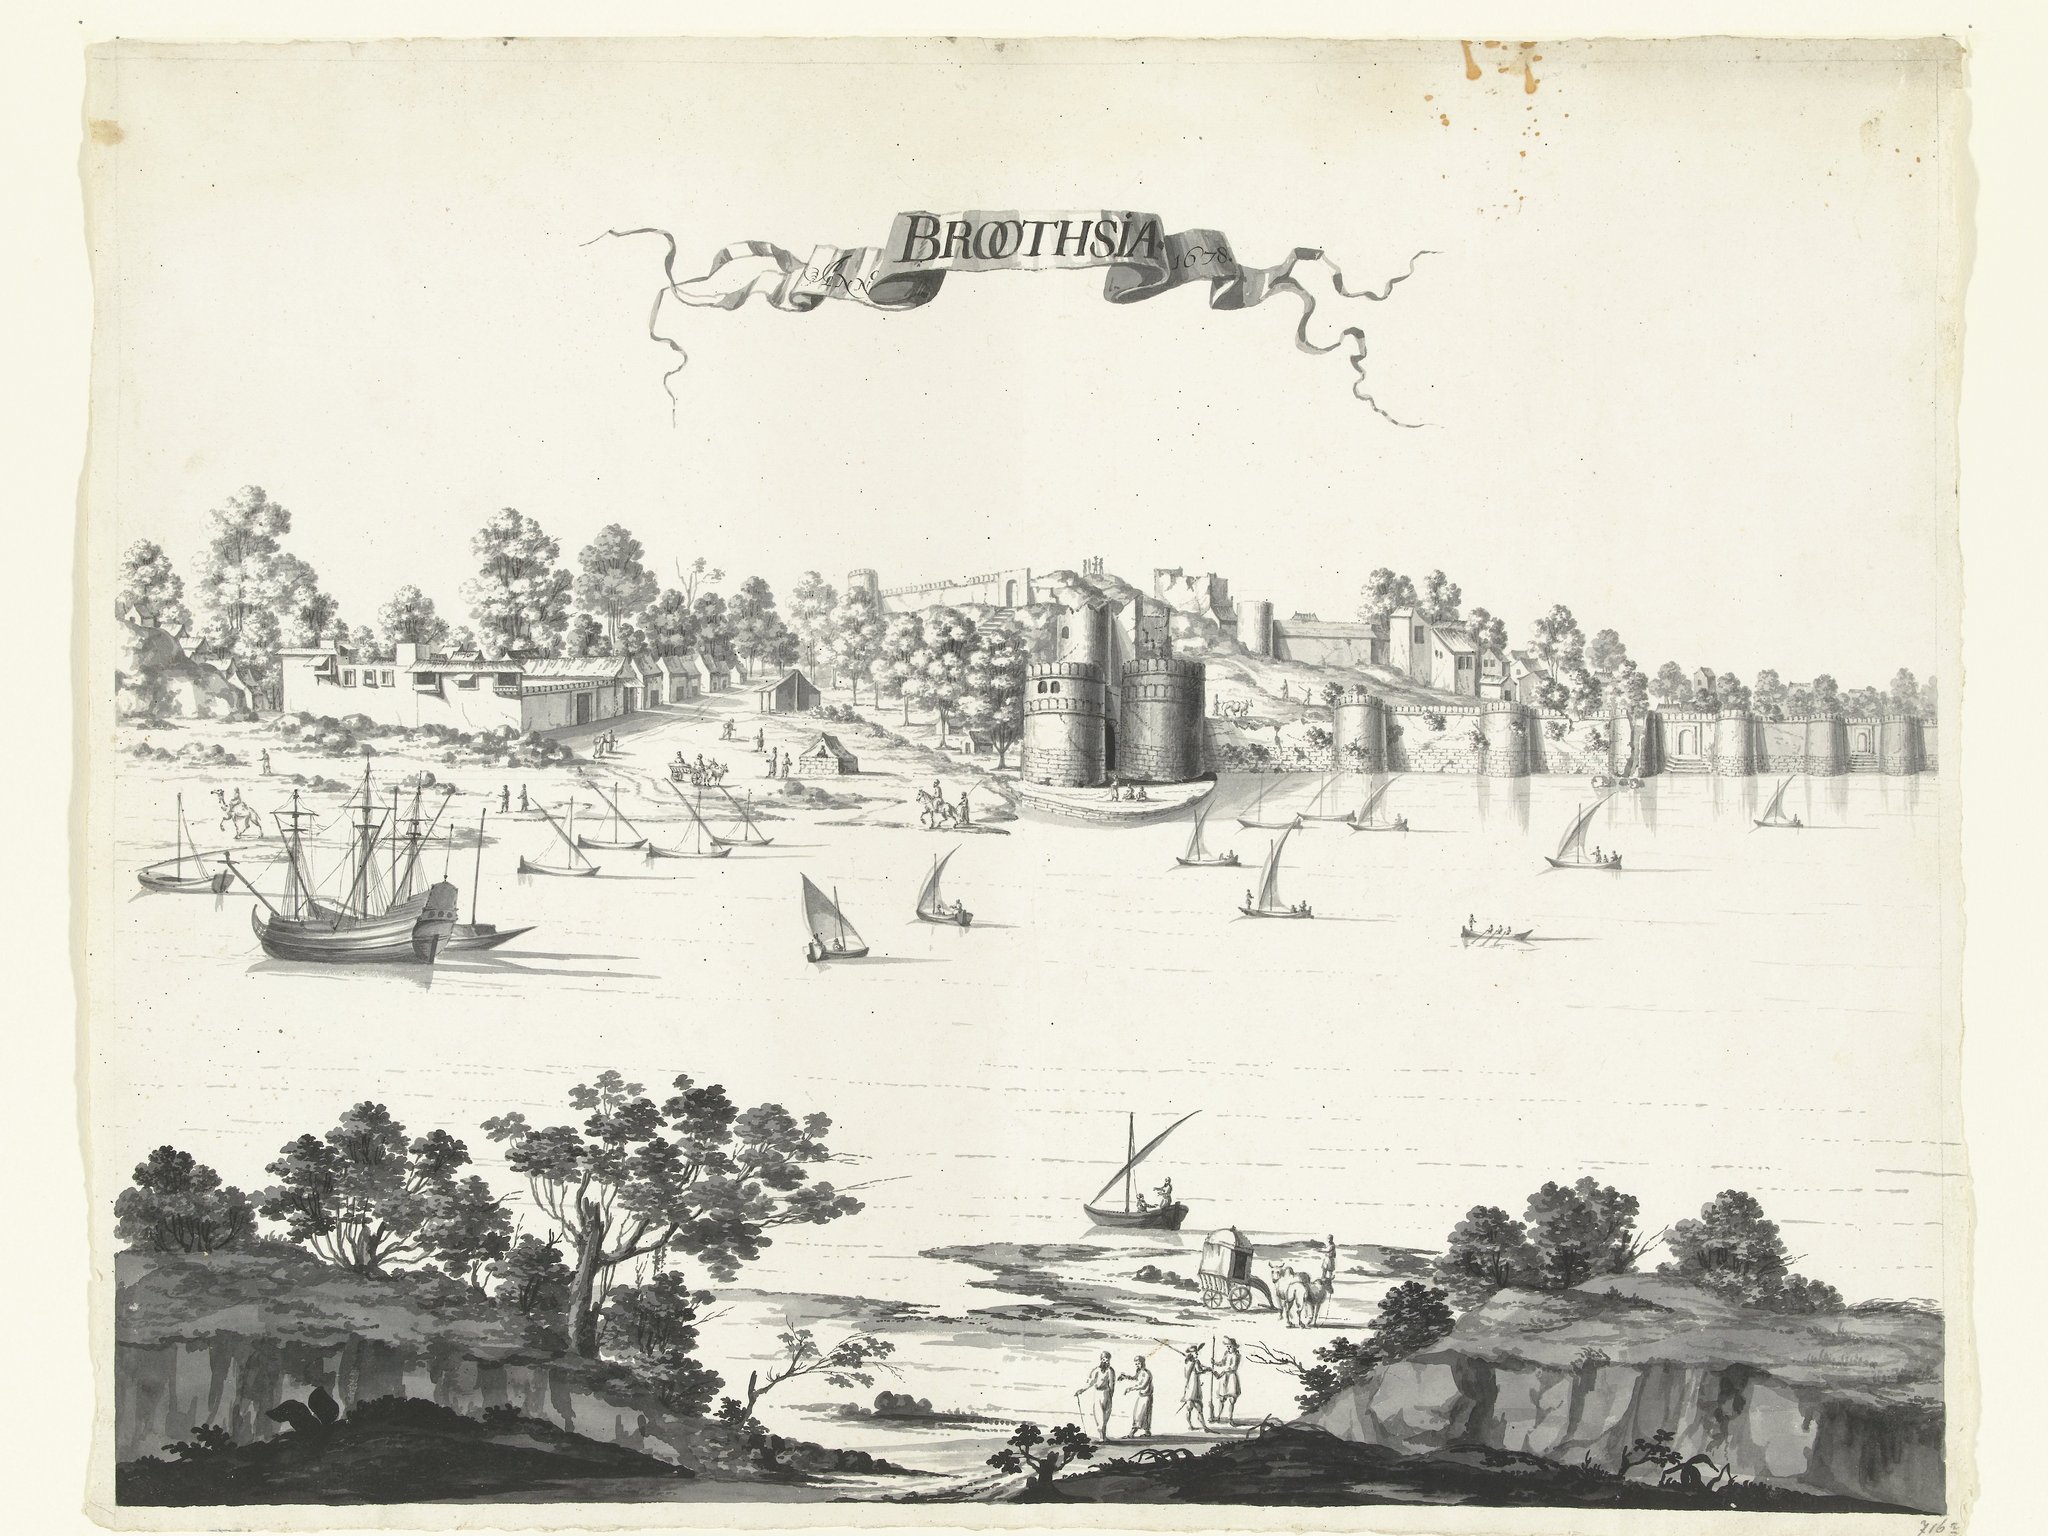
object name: drawing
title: Broothsia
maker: Anonymous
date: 1678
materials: paper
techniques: brush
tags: harbour, prospect of city, town panorama, silhouette of city